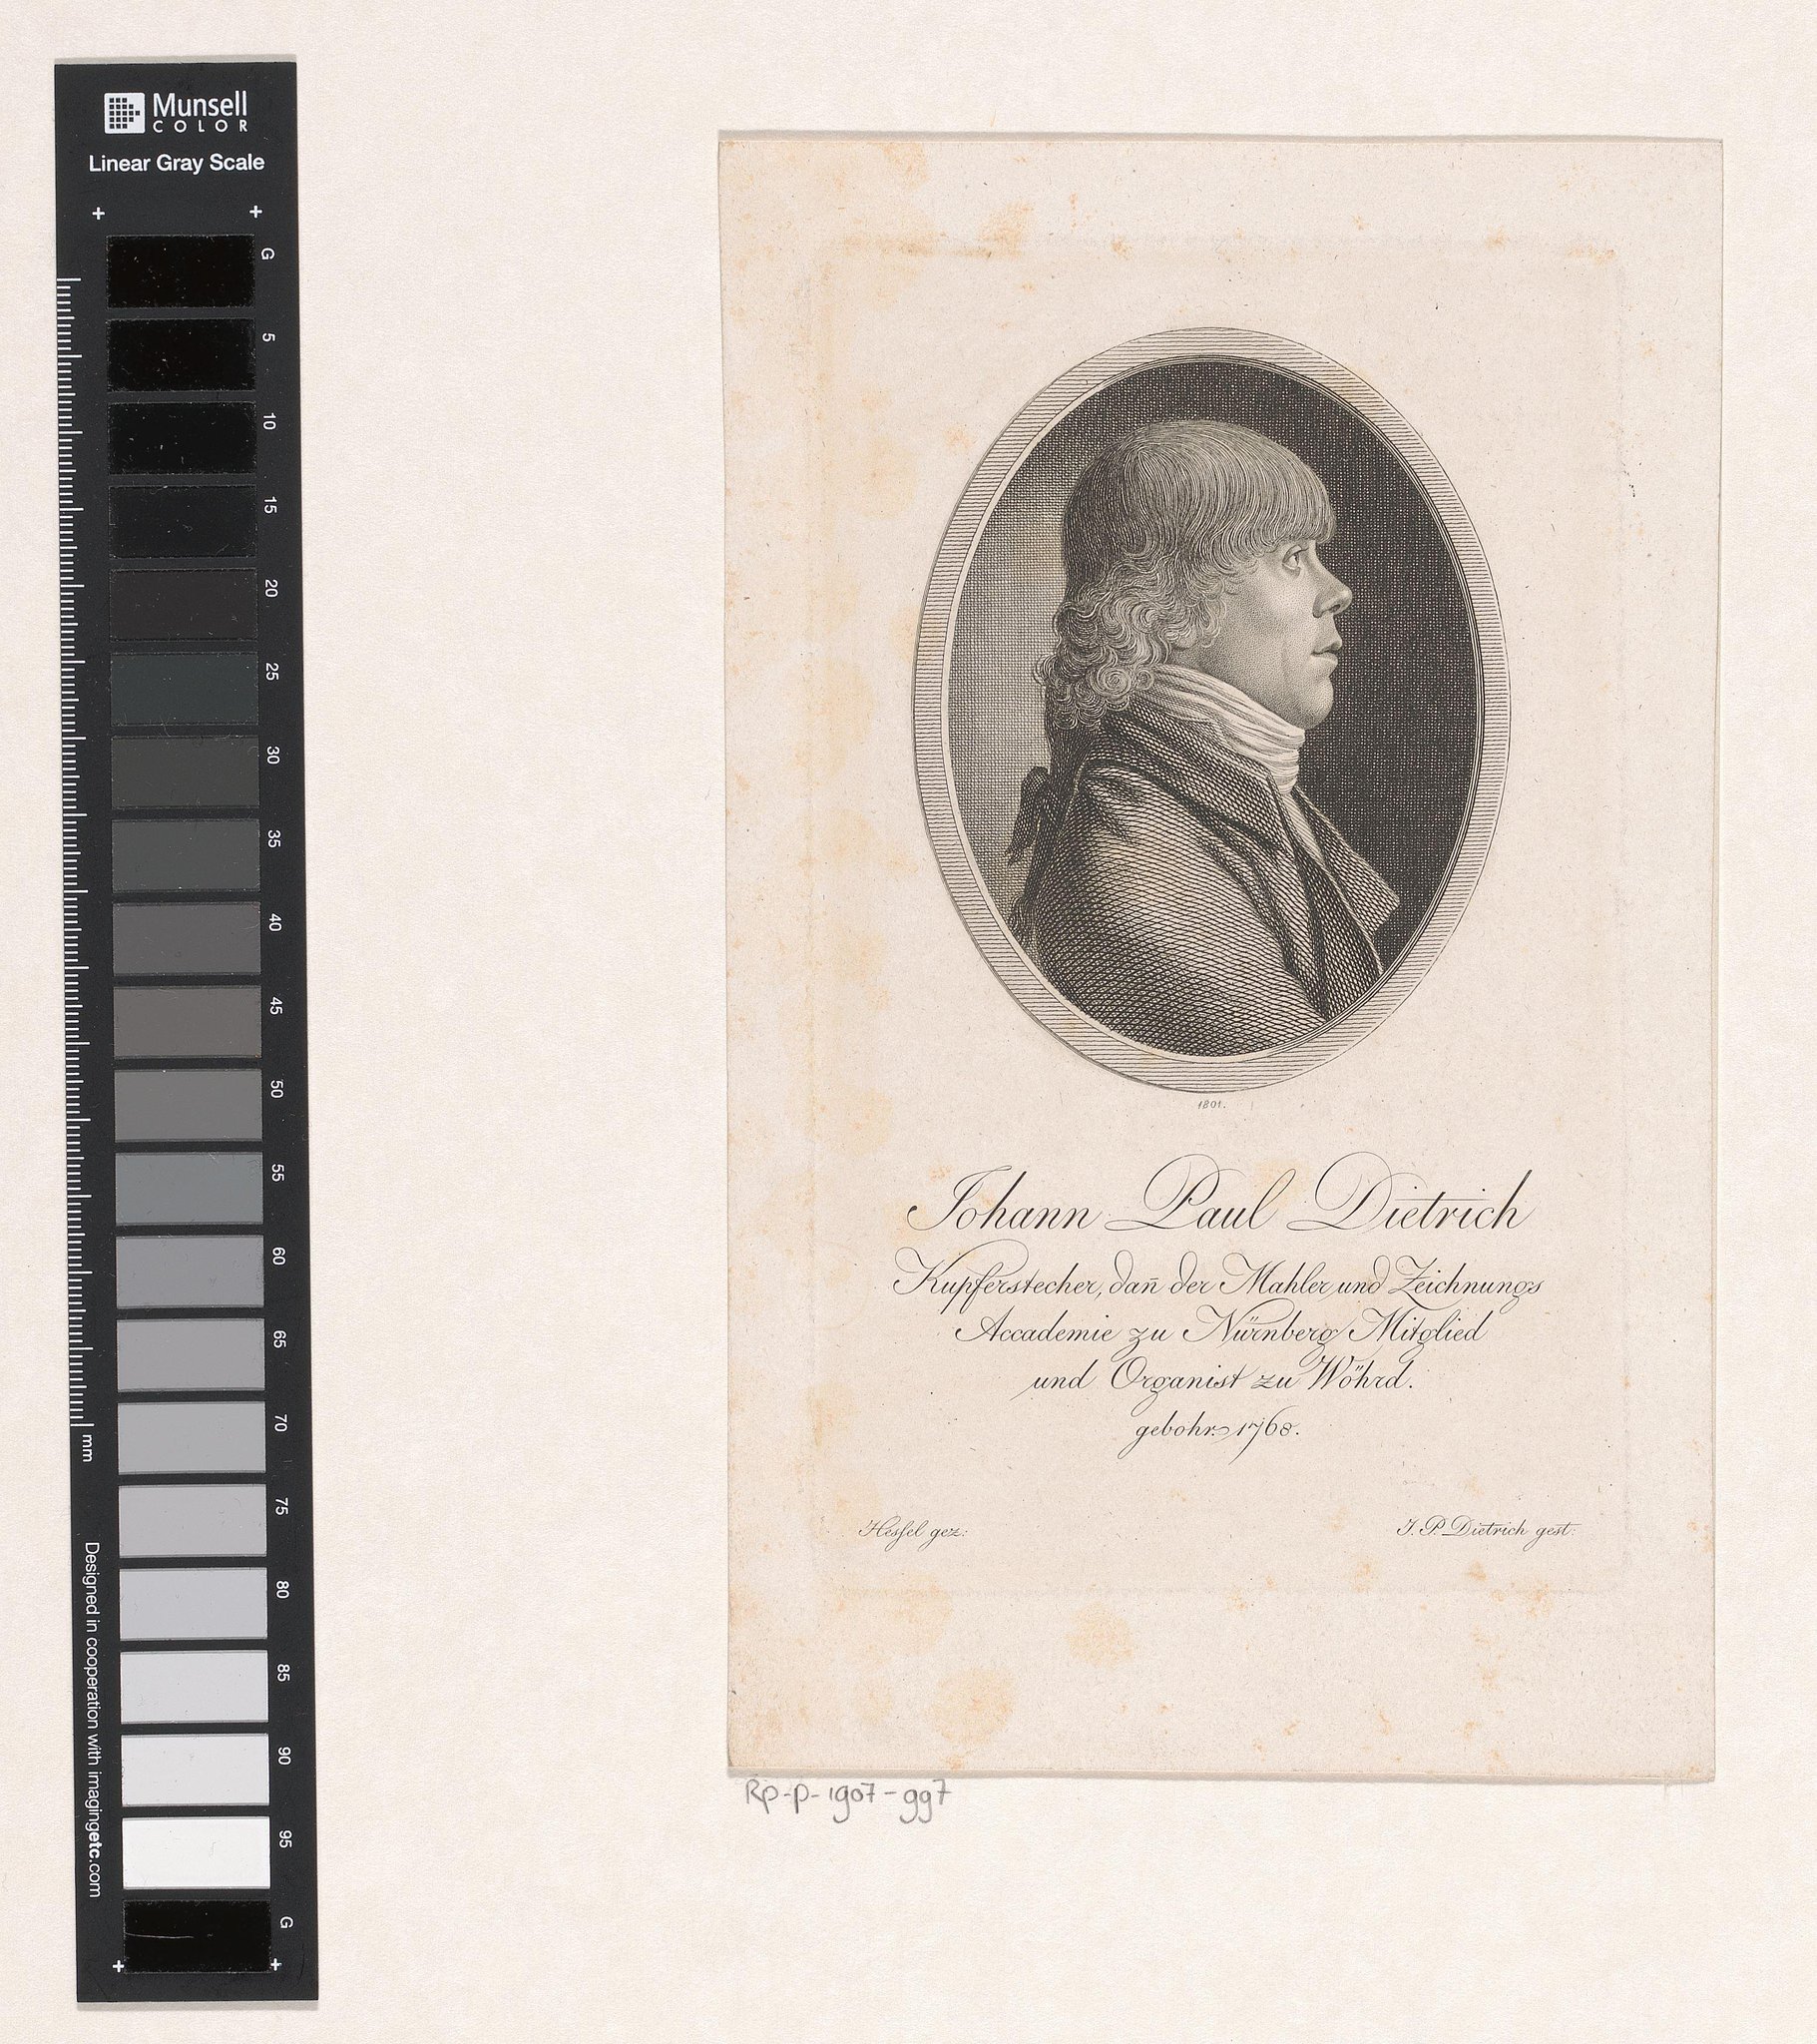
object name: print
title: Portret van Johann Paul Dietrich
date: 1801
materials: paper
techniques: engraving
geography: nuremberg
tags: historical persons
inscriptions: collector's mark: Lugt 2228